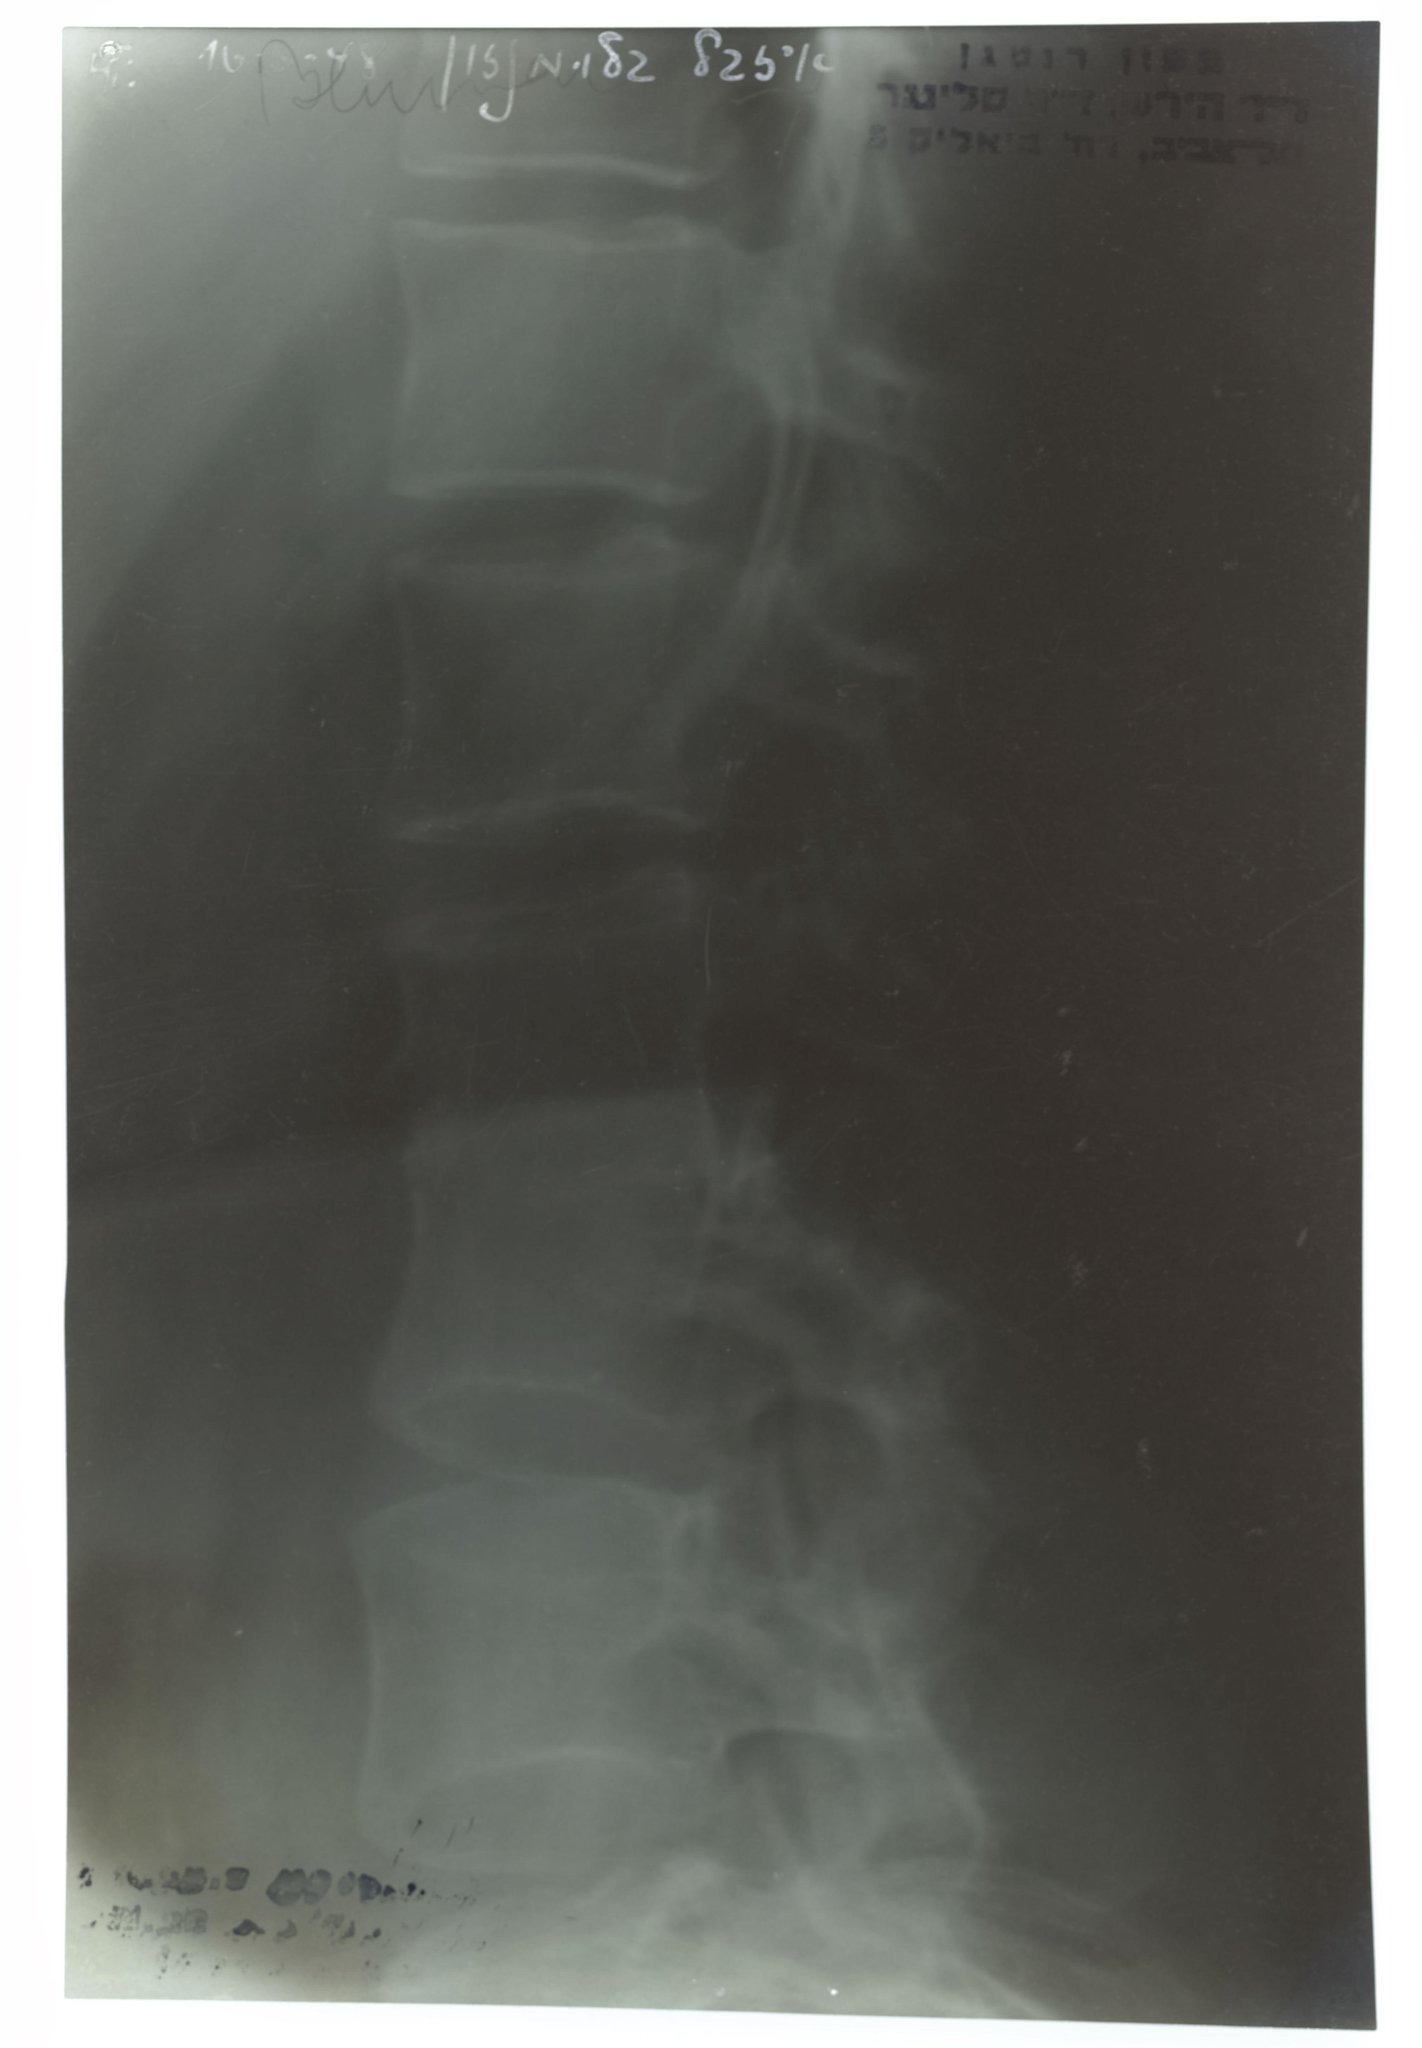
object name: photograph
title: Röntgenfoto van de met TBC geïnfecteerde ruggenwervel van Isabel Wachenheimer, gedateerd op 16 juni 1948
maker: Anonymous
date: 1948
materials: photographic support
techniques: gelatin silver print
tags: leiden, isabel wachenheimer-elon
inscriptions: date: ‘16-6-48 15 n.182 825"/c’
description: Röntgenfoto van de met TBC geïnfecteerde ruggenwervel van Isabel Wachenheimer.